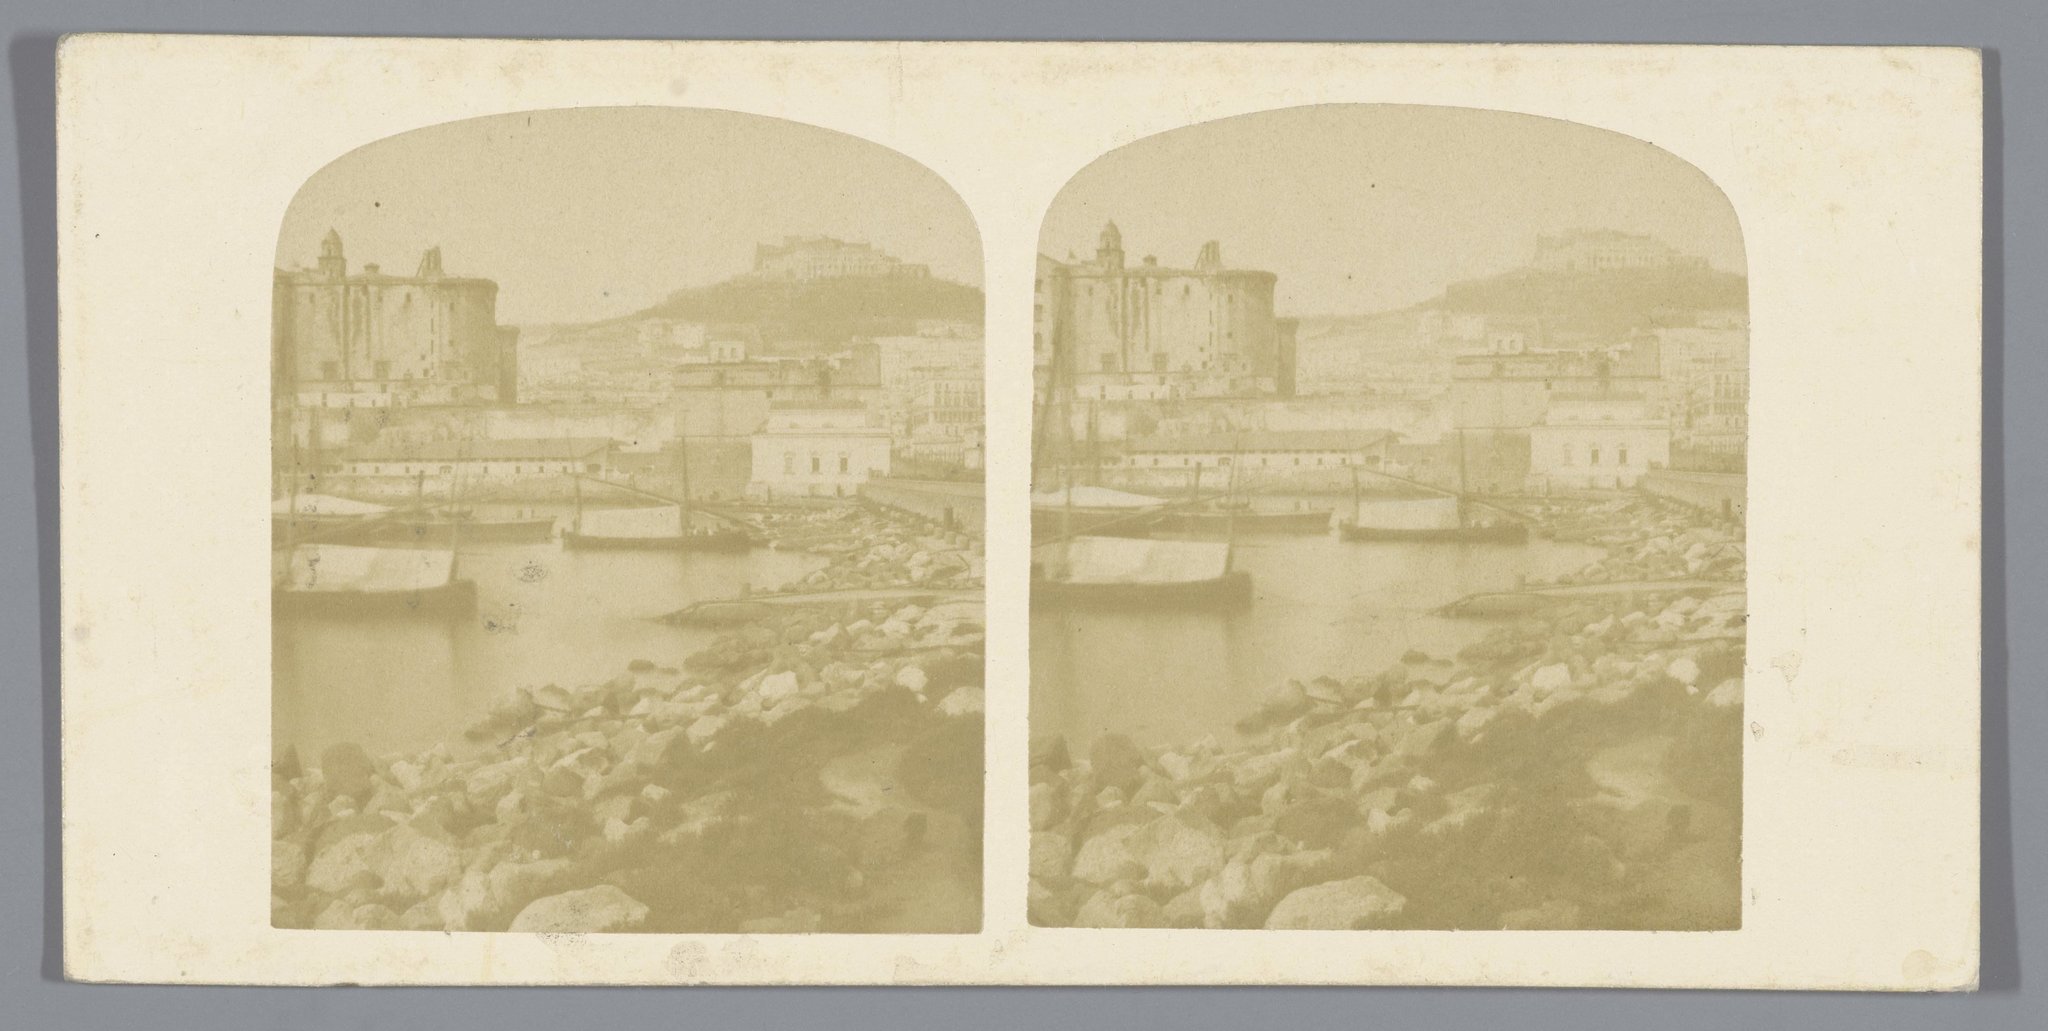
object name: stereograph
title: Gezicht op de haven van Napels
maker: Anonymous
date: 1850-1880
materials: cardboard, photographic support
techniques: albumen print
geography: naples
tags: harbour, naples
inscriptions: inscription: ‘Vue prise du phare Naples’